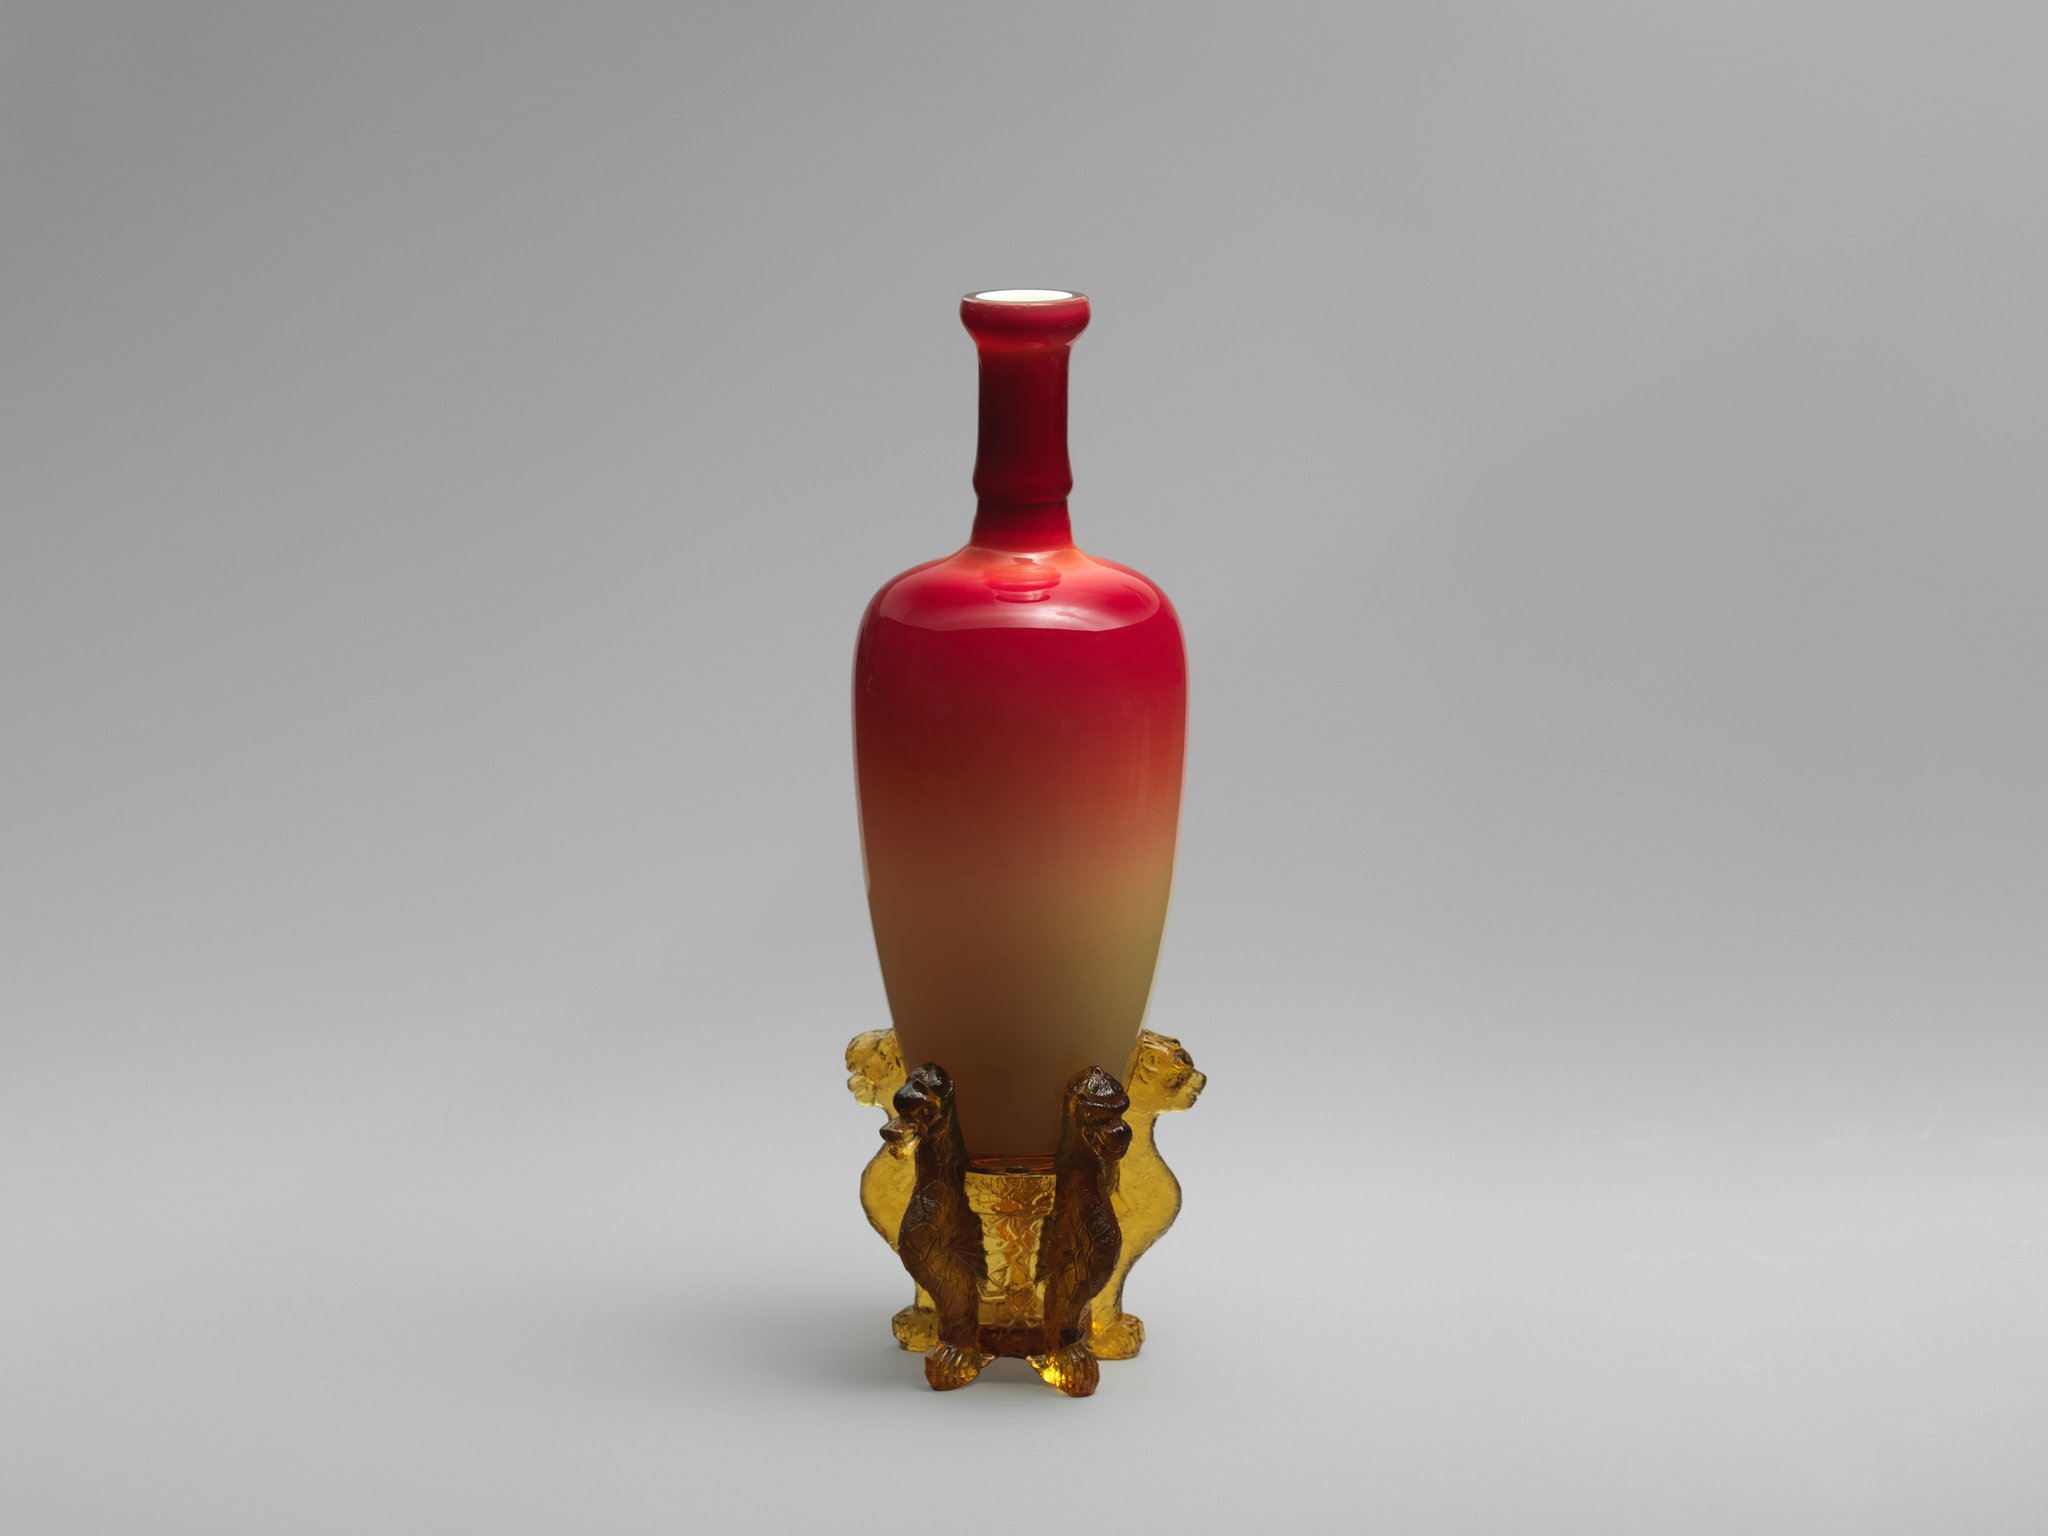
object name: vase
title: “Morgan Vase” and stand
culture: american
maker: hobbs, brockunier and company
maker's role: manufacturer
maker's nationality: american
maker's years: 1863-1891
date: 1886-1891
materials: amber, glass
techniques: glassblowing, pressed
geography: united states